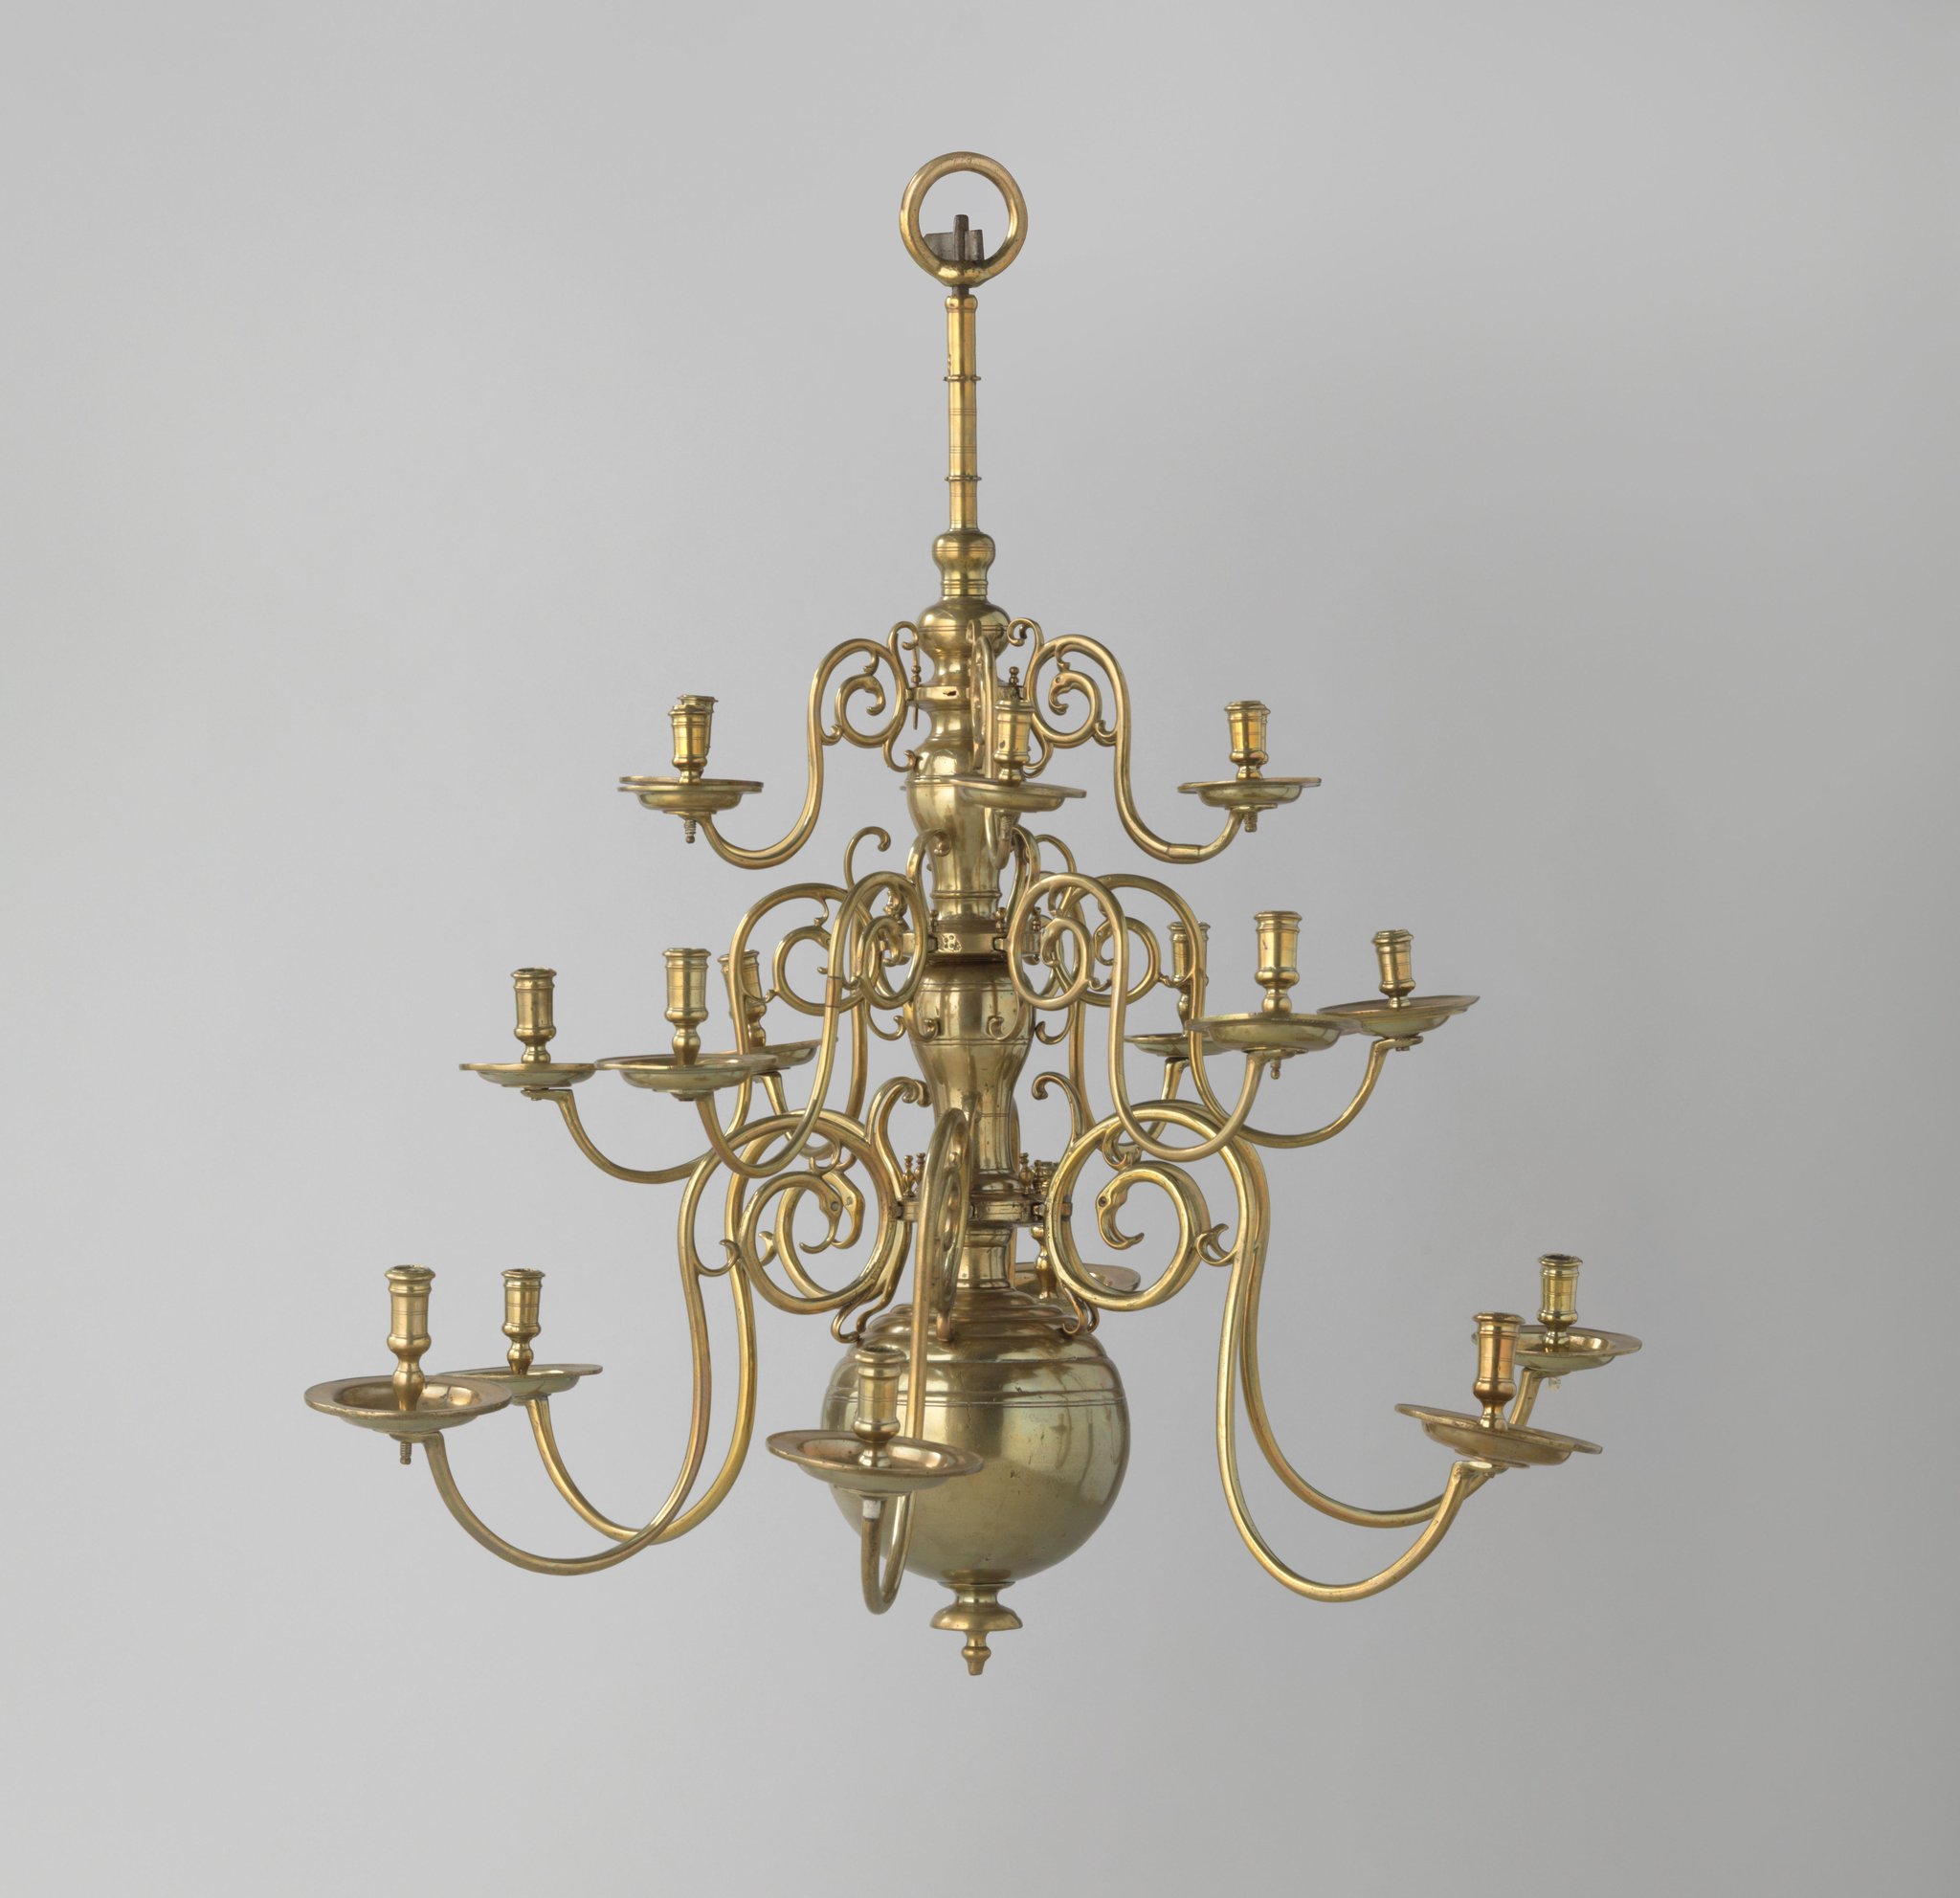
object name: chandelier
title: Arm met kaarsenhouder van kaarsenkroon van drie hoogten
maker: Anonymous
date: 1675-1725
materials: brass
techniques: casting, screwed, turning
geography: southern netherlands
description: Kaarsenarm behorende bij een messing kaarsenkroon van drie hoogten. De S-vormige arm heeft een krul en gaat naar buiten toe over in het platte verdikking met een schroefgat. Daarin is de kaarsenhouder met de vetvanger vastgezet. De kleine vetvanger is aan de onderzijde geribd geprofileerd rond de opening en heeft verder twee maal twee gegroefde ringen. De cylindrische kaarsenhouder, die een geprofileerde uitstekende rand, twee gegroefde ringen en een verdikking onderaan heeft, gaat over in een baluster met onderaan het eind met schroefdraad. Dit is de vierde arm van de onderste standring, ongenummerd. De pin, om de arm aan de standring te bevestigen, heeft een brede balustervorm.